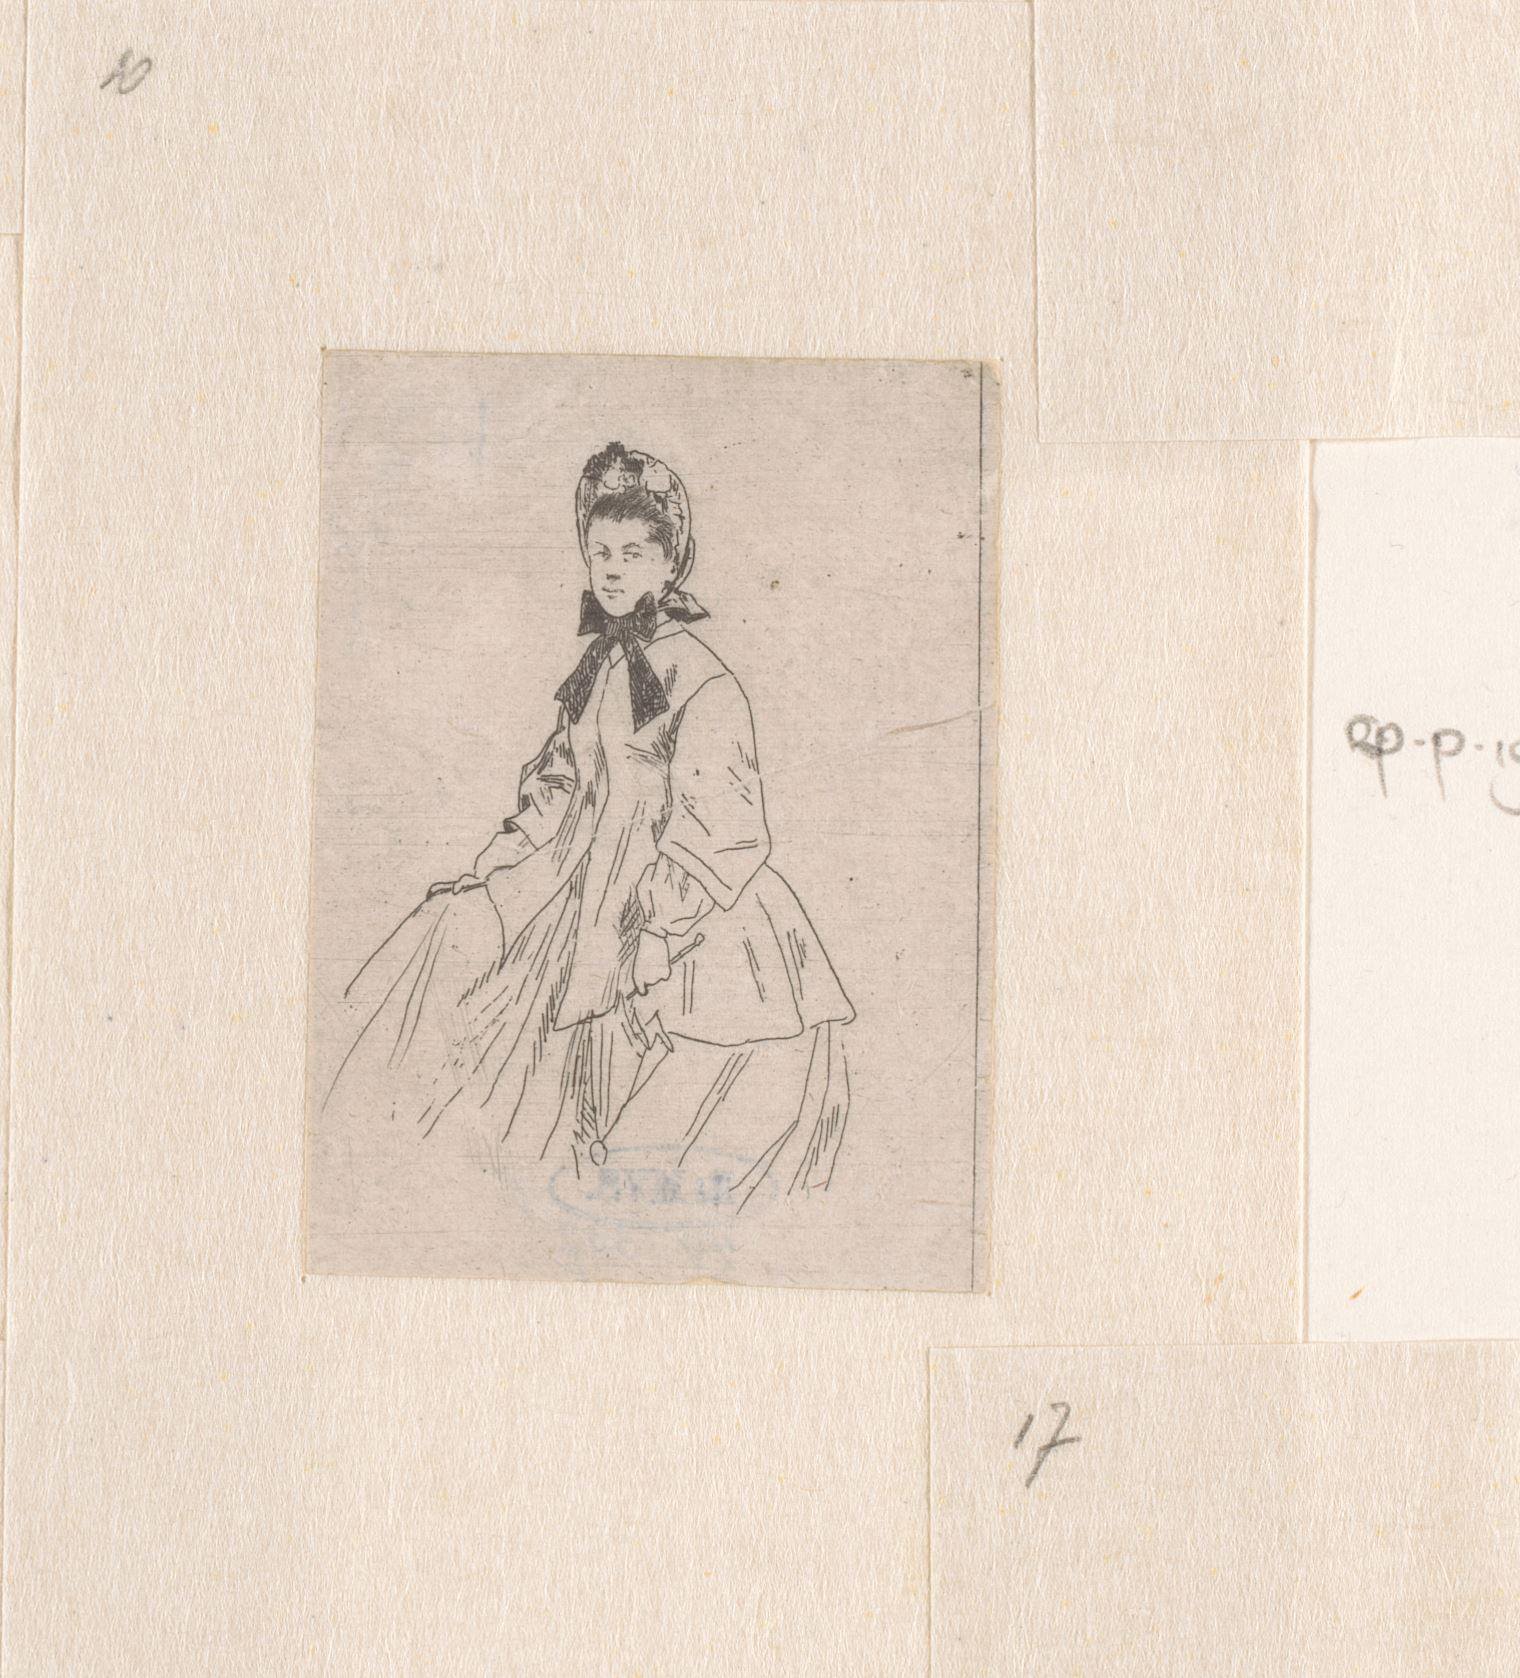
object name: print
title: Portret van een onbekende vrouw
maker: félicien rops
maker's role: draughtsman, print maker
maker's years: 1833-1898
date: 1863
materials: paper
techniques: etching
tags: adult woman, parasol, sunshade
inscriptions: collector's mark: Lugt 2228